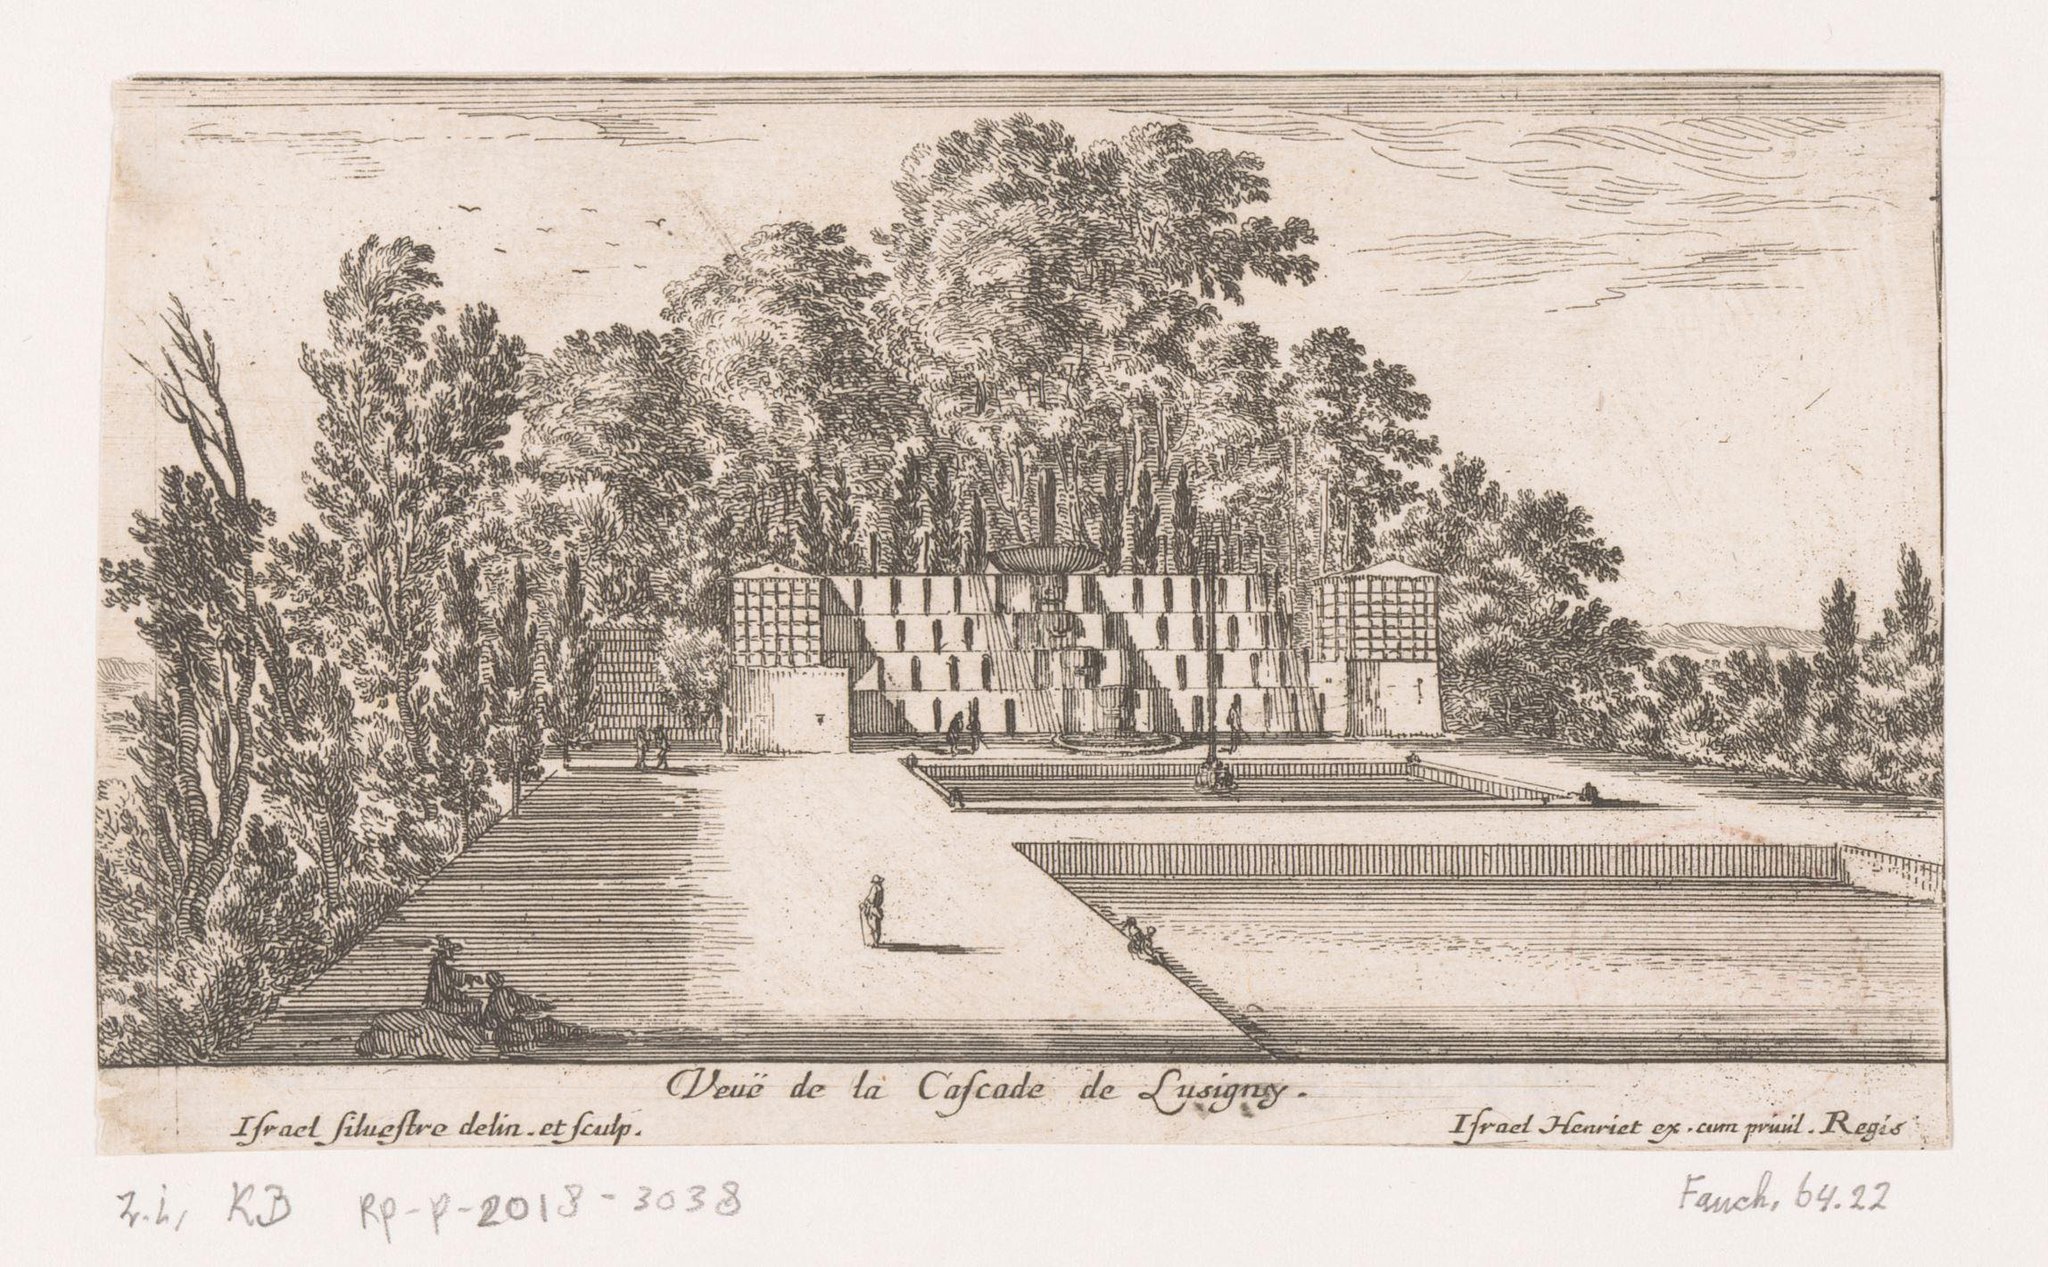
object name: print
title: Veuë de la Cascade de Lusigny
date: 1654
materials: paper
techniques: etching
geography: paris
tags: french or architectonic garden; formal garden, garden cascade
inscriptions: collector's mark: Lugt 240, collector's mark: Lugt 2228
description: Prent maakt deel uit van een ongenummerde serie van 21 prenten.